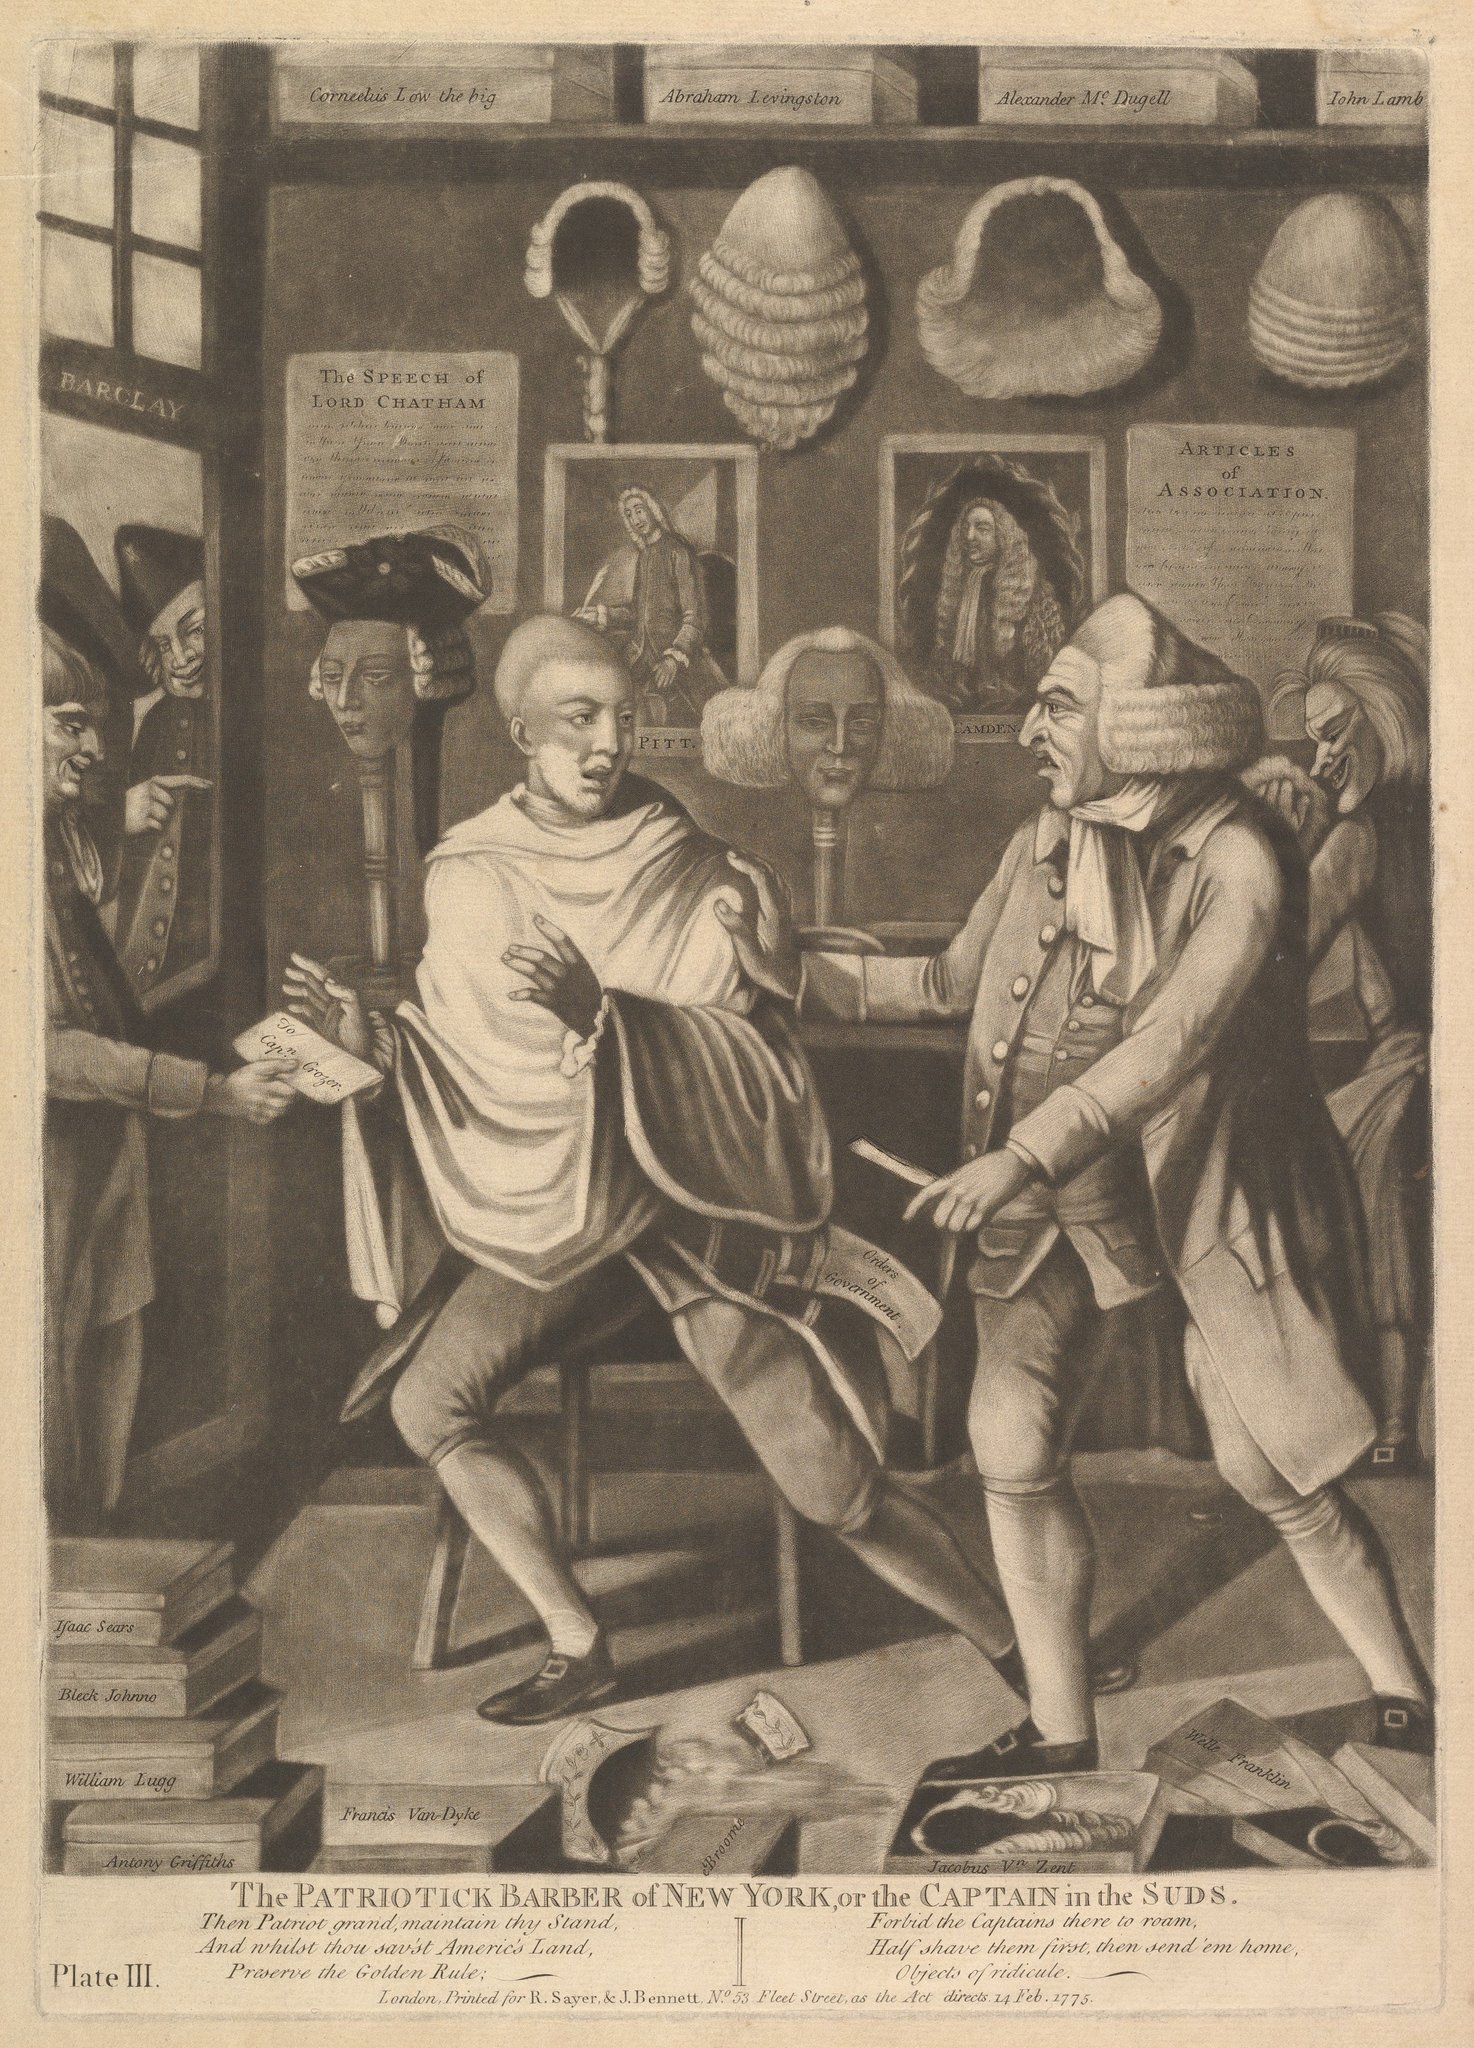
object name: print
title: The Patriotick Barber of New York, or the Captain in Suds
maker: philip dawe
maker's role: artist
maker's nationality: british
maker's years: 1745-1809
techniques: mezzotint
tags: men,wigs,barbers